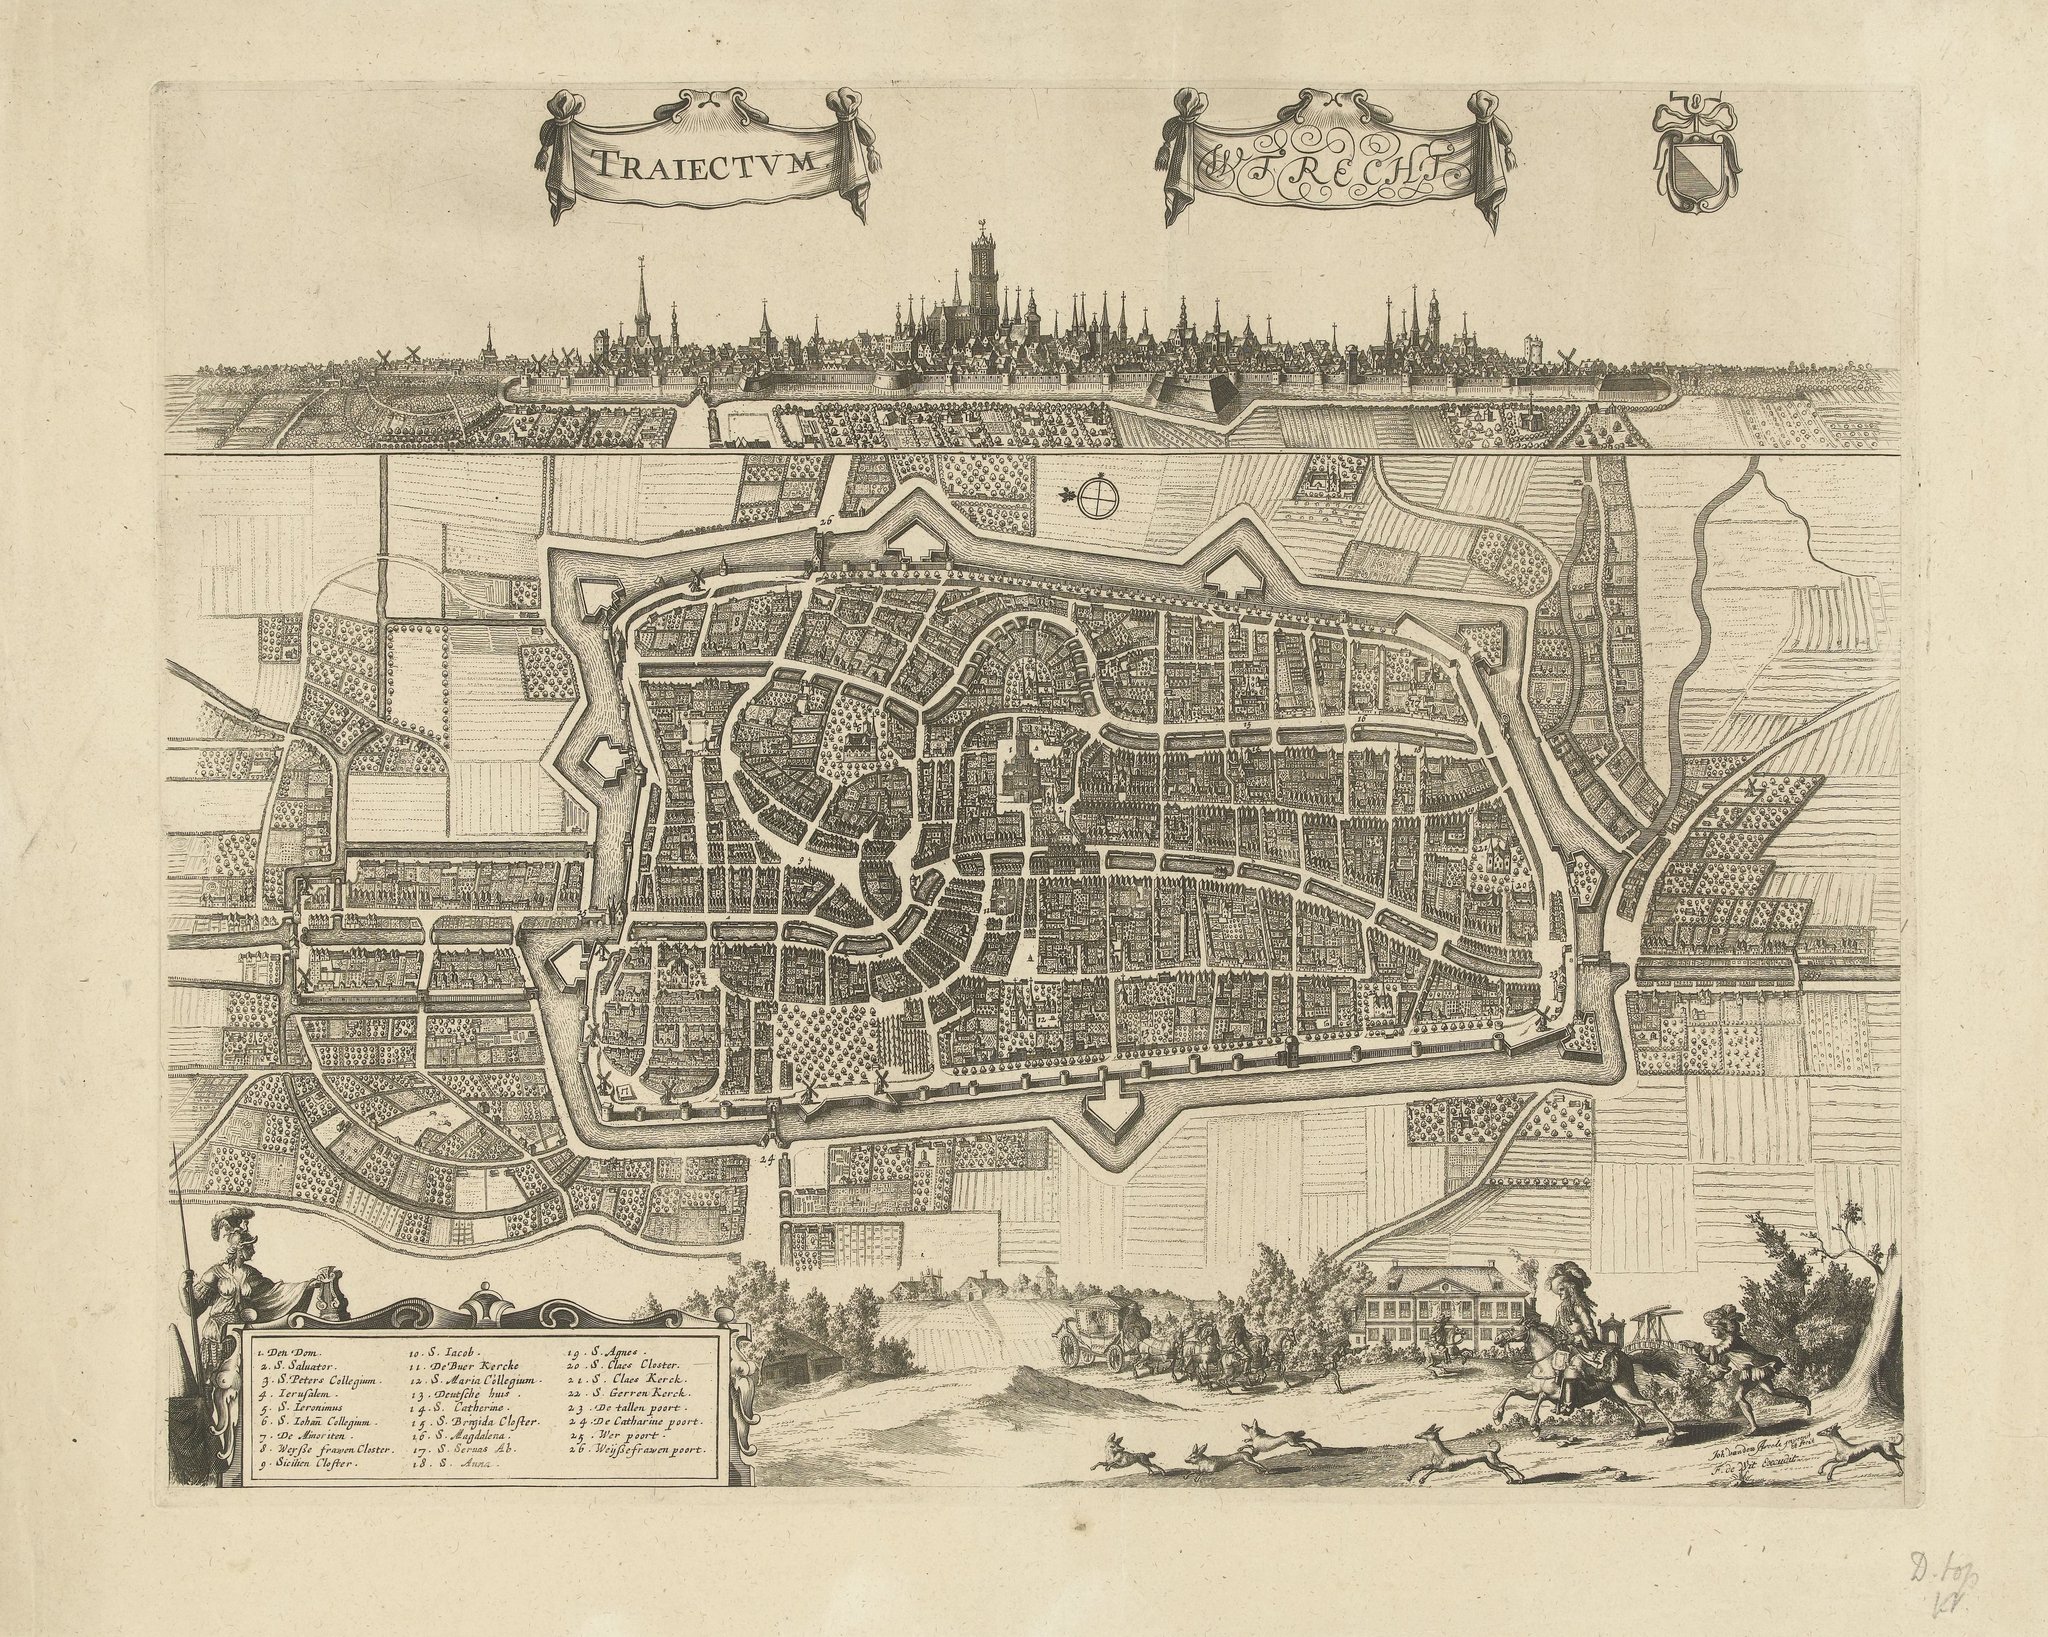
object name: print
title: Plattegrond van de stad Utrecht met stadsgezicht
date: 1657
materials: paper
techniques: engraving, etching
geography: amsterdam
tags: riding a horse, ass, or mule; rider, horseman, coat of arms (as symbol of the state, etc.), city-view in general; 'veduta', (story of) minerva (pallas, athena), hunting dogs, maps of cities, passenger carriage, country-house, utrecht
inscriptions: collector's mark: Lugt 2166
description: Boven een stadsgezicht met daarop rechtsboven het wapen van de stad Utrecht. Daaronder een plattegrond in vogelvluchtperspectief. Linksonder een cartouche met de legenda, links daarvan Minerva. Verder een aantal figuren, een buitenhuis, een koets met paarden, ruiters en jachthonden.